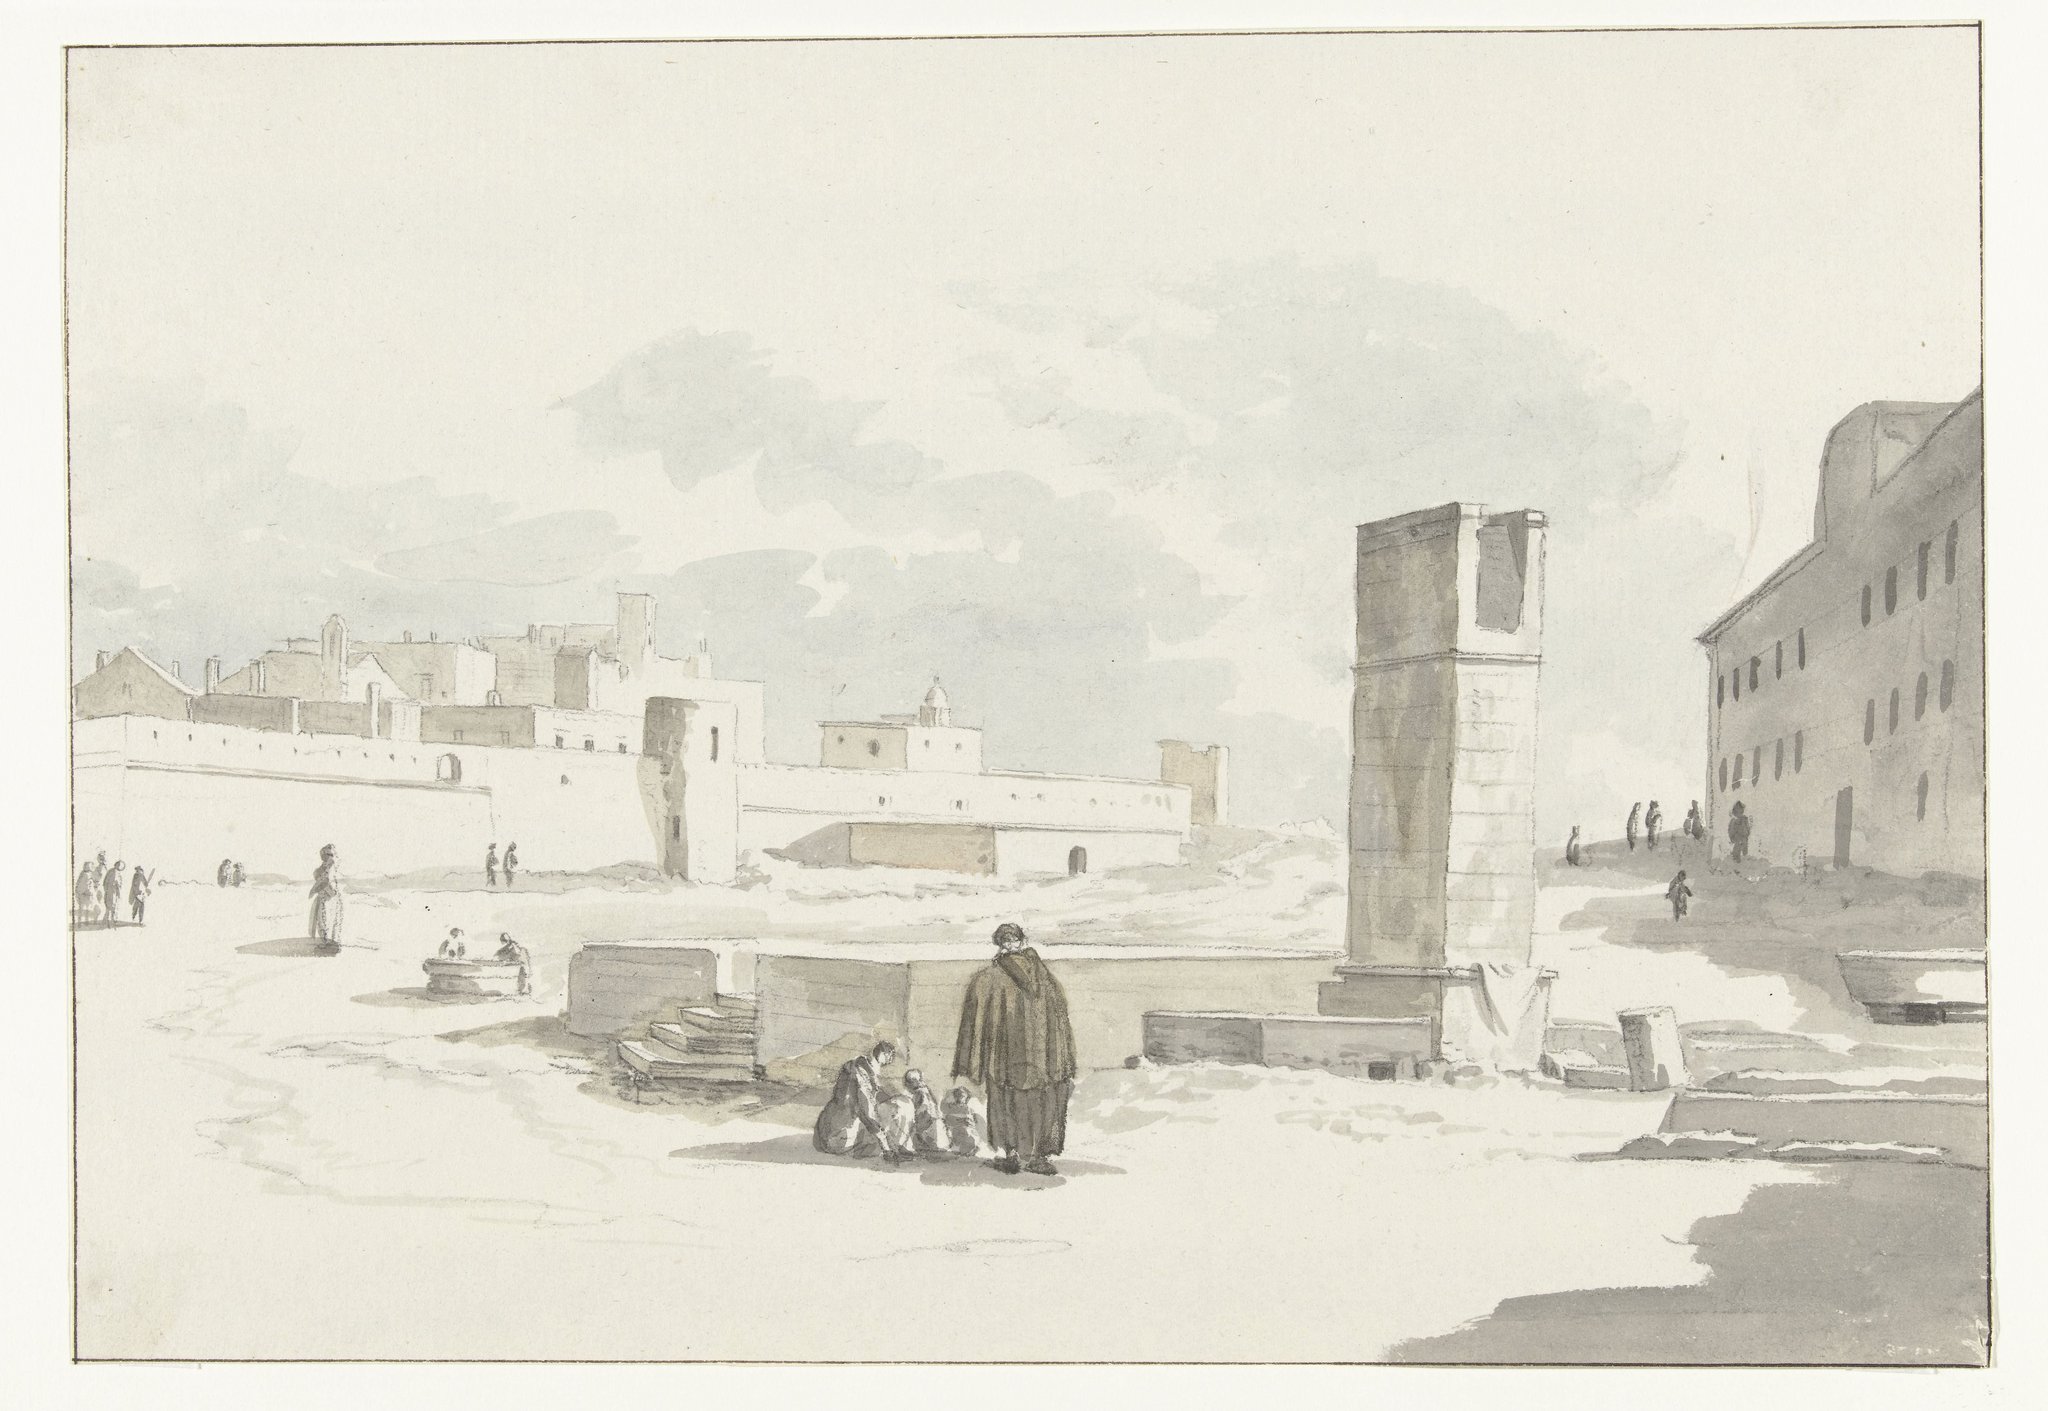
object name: watercolor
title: Stadsgezicht in Giovenazzo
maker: louis ducros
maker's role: draughtsman, print maker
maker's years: 1748-1810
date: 1778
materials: chalk, paper, watercolor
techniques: brush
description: Tekening uit het album 'Voyage en Italie, en Sicile et à Malte', 1778.